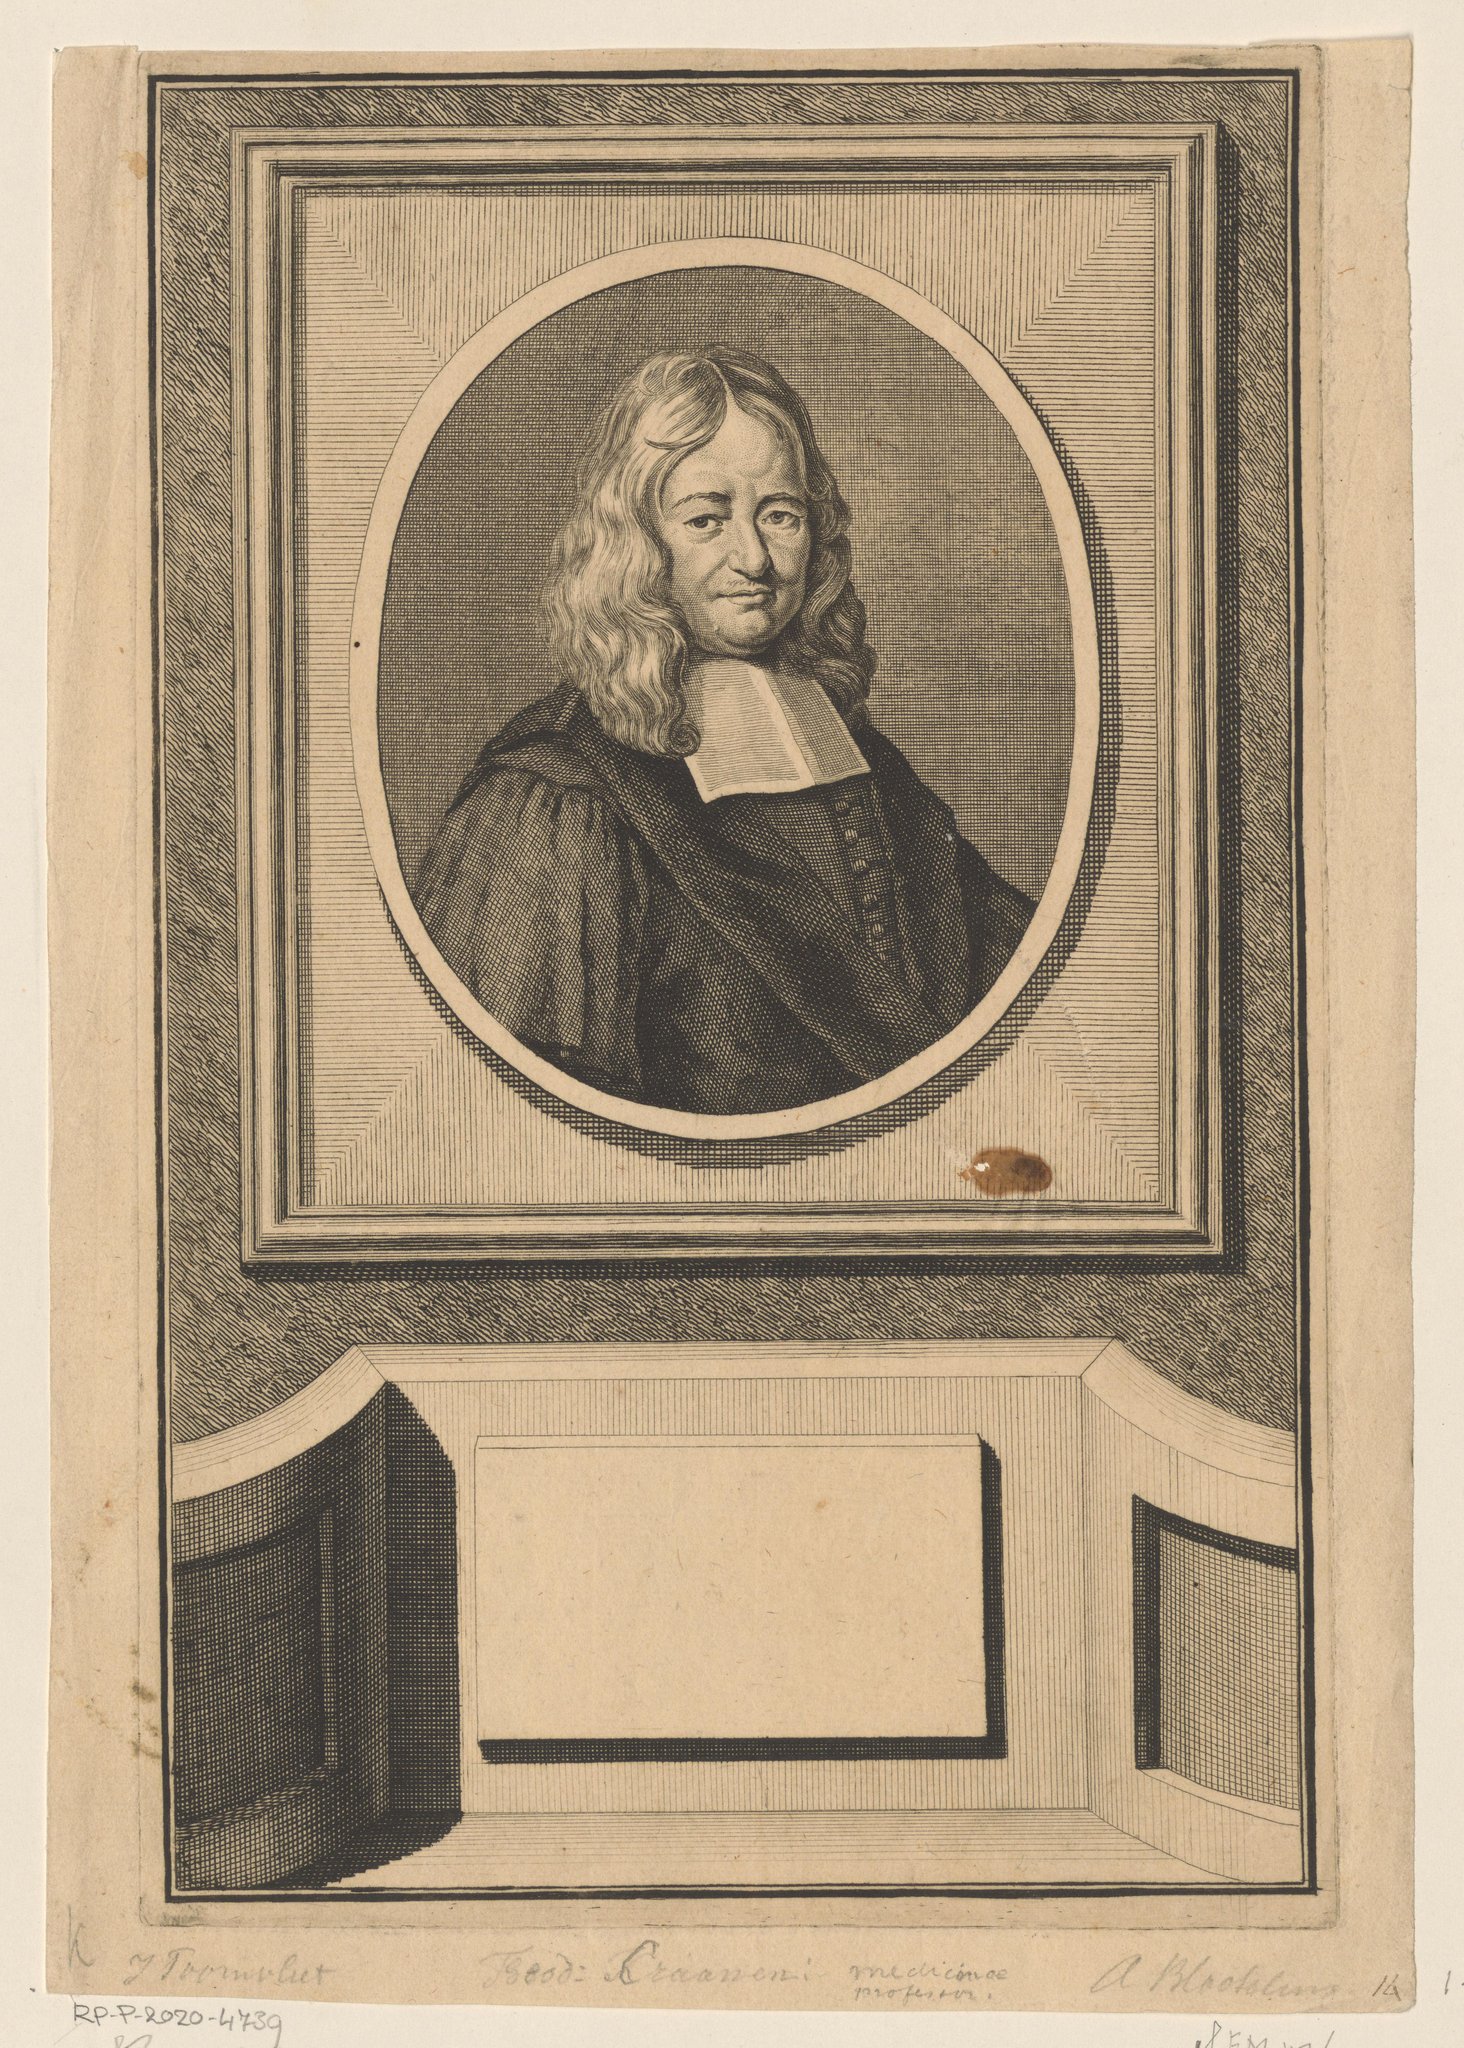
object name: print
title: Portret van Theodorus Craanen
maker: Anonymous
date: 1720-1723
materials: paper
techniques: etching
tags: historical persons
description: Prent mogelijk uit: Fundatoris, Curatorum et Professorum celeberrimorum aliorumque illustrium virorum, quorum gratia (...). Leiden: Pieter van der Aa, [1720-1723].